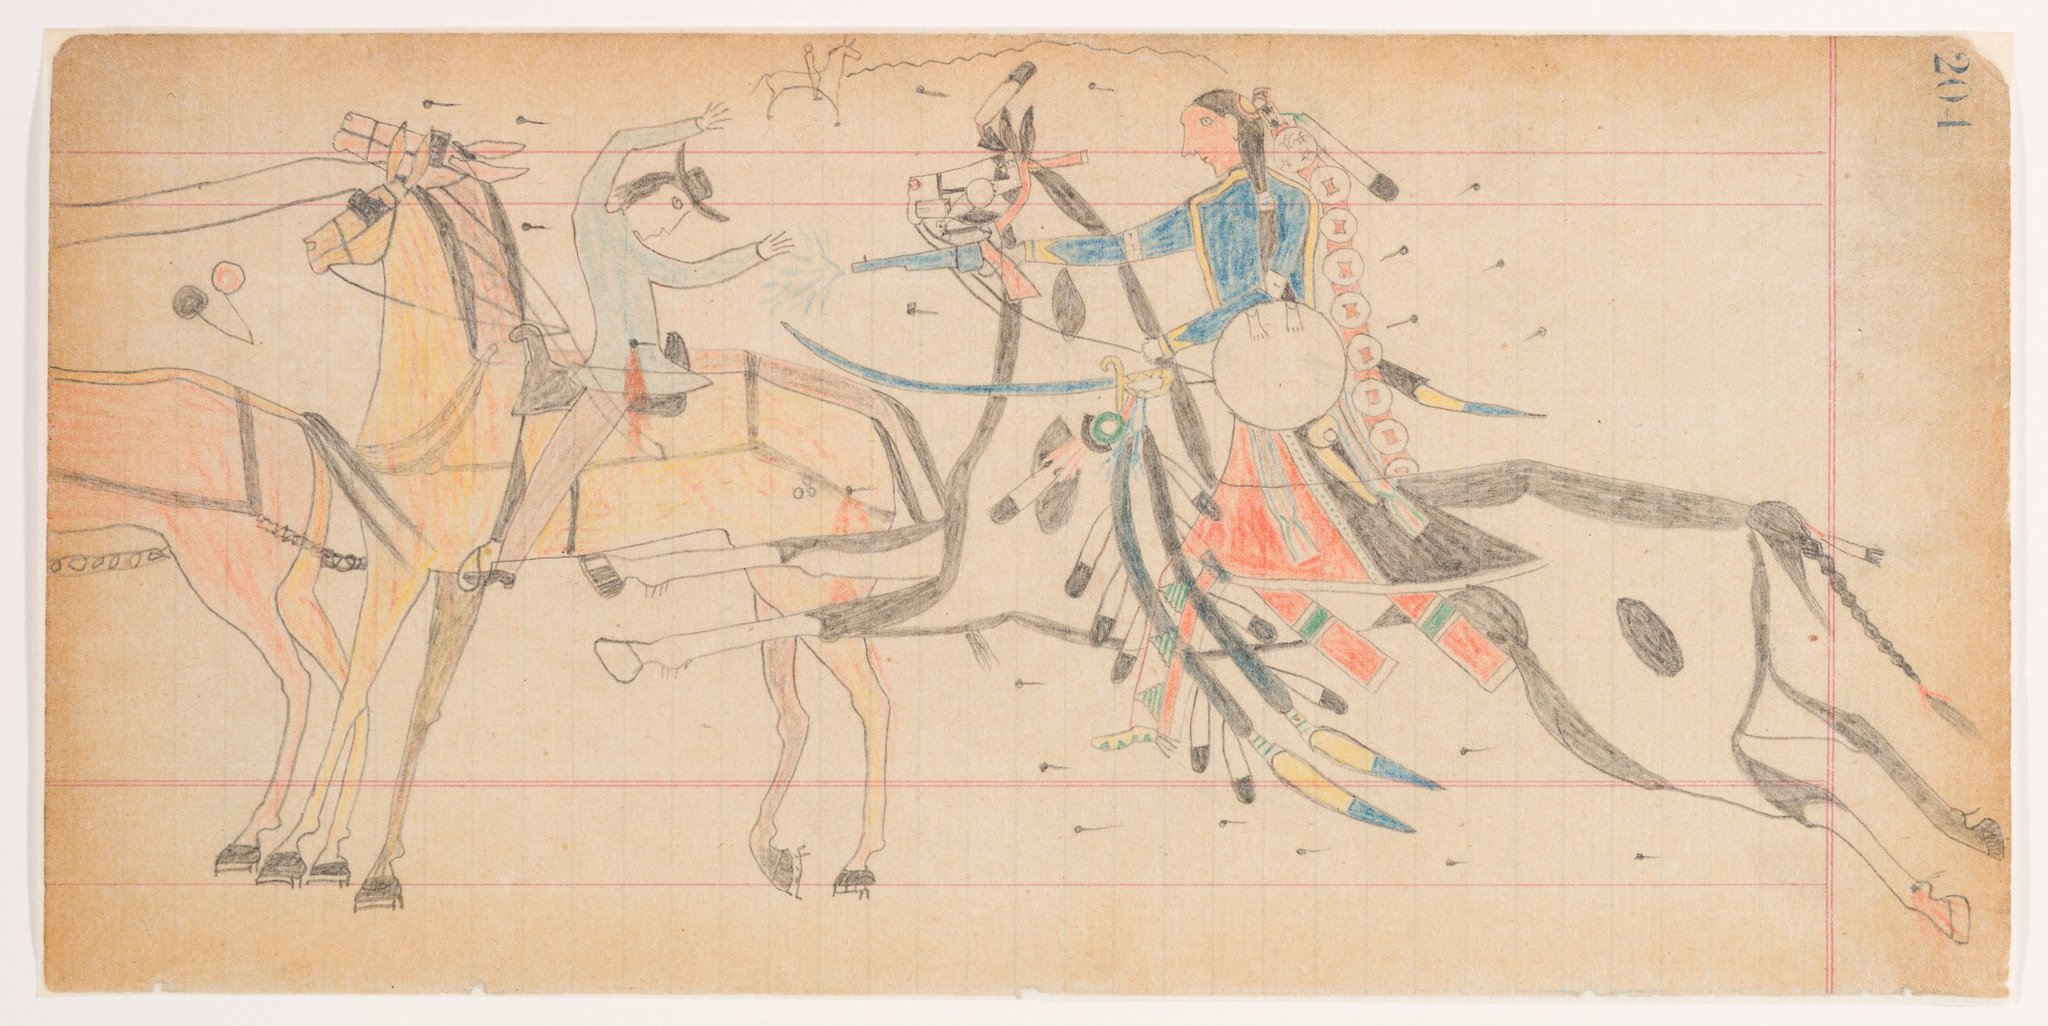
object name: drawing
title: Indian Killing White Man (Vincent Price Ledger)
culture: arahapo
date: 1880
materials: paper, pencil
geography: united states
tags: firearms,men,horses